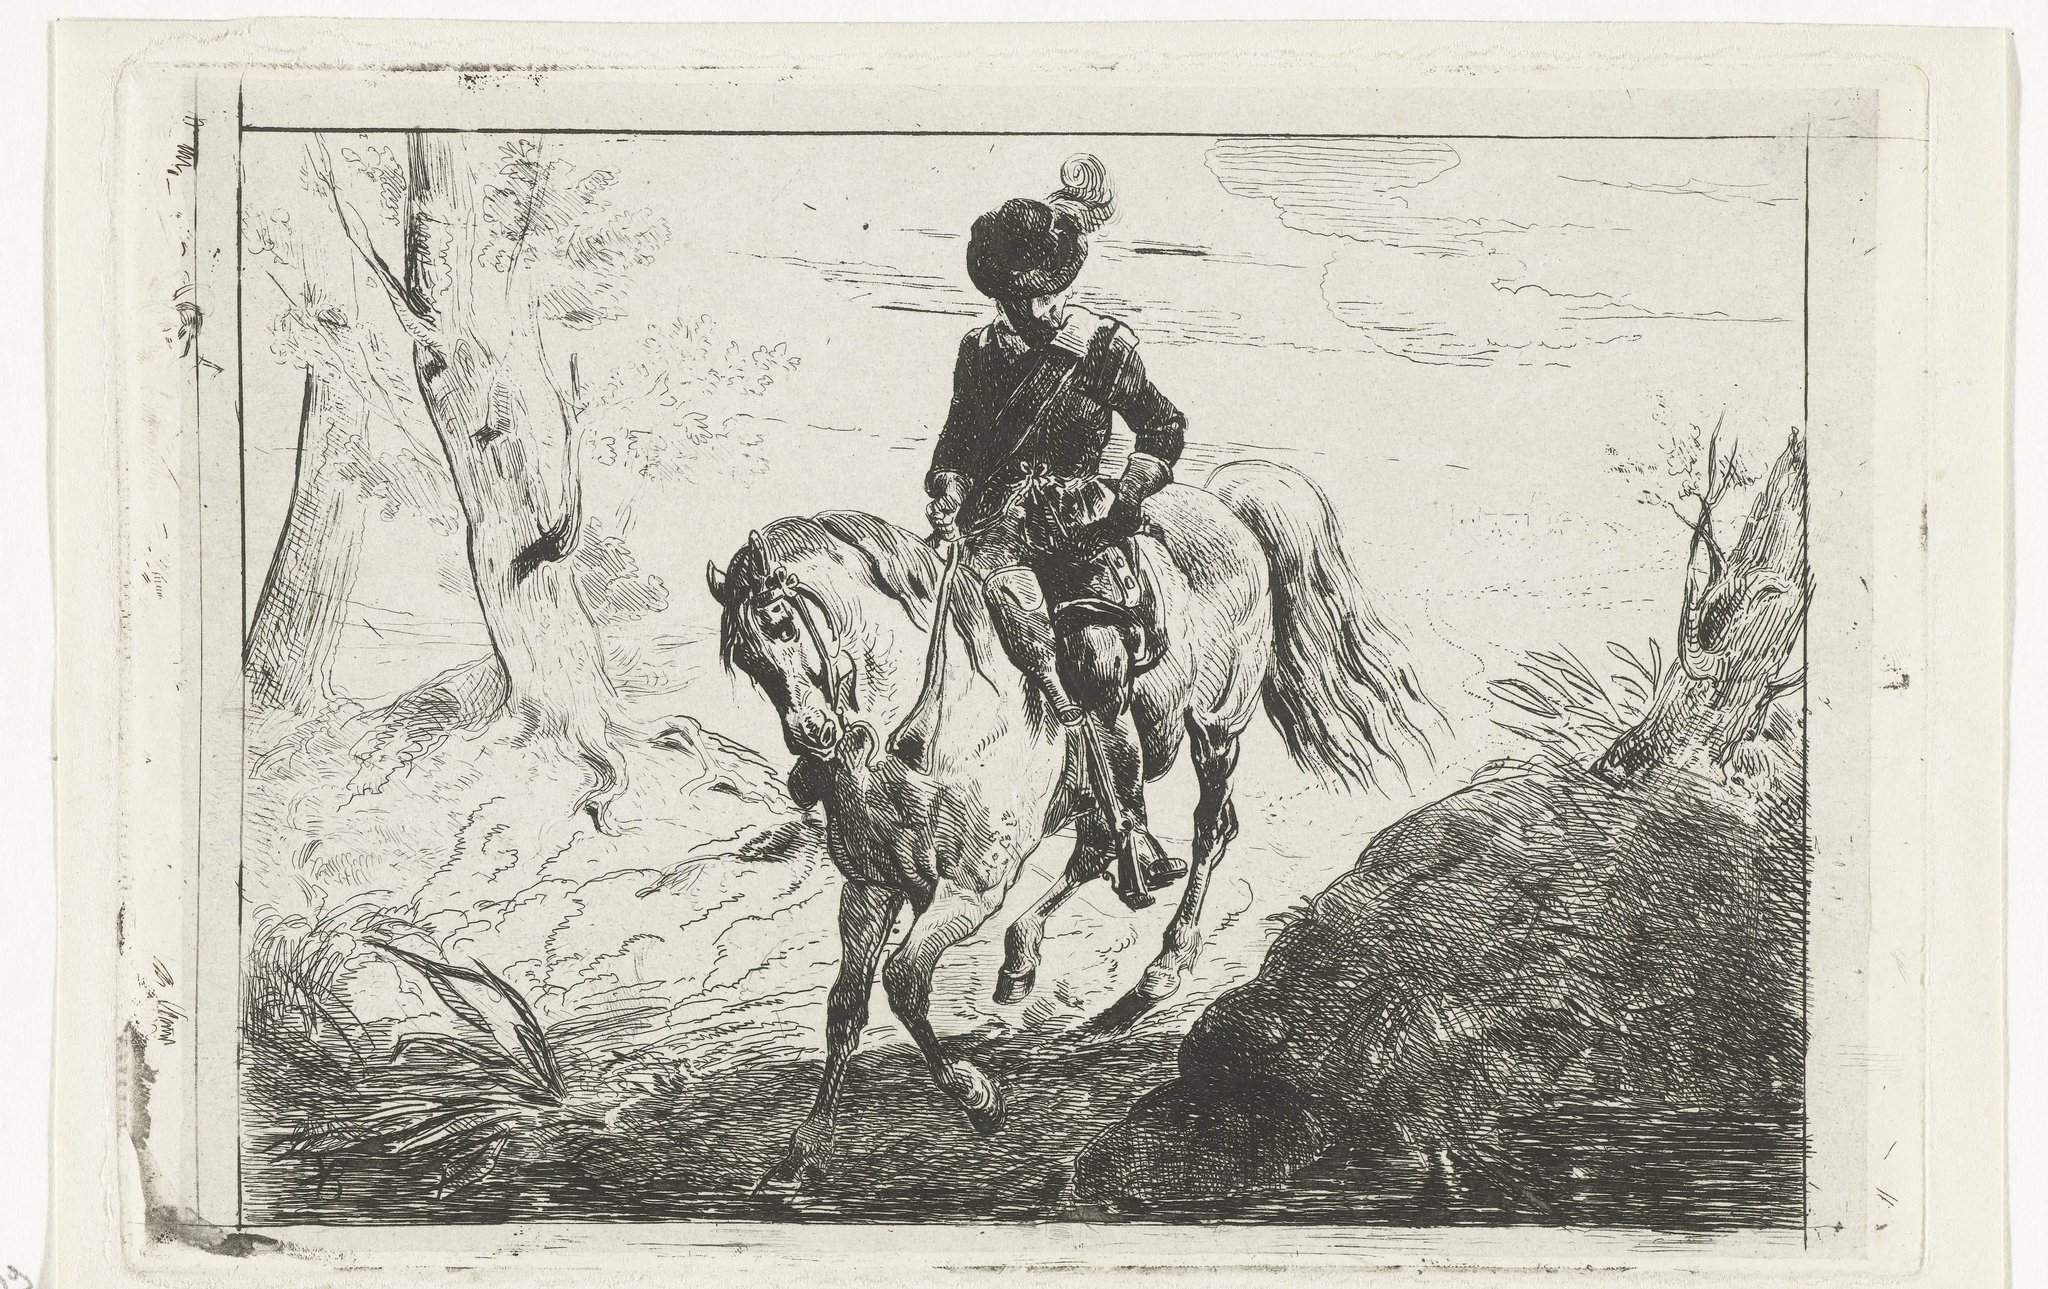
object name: print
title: Ruiter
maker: karel frederik bombled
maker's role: draughtsman, print maker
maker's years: 1822-1902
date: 1832-1902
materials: paper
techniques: drypoint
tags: riding a horse, ass, or mule; rider, horseman, forest path or lane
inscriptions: collector's mark: Lugt 2228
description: niet genoemd in literatuur. 9 staten aanwezig in het RMA